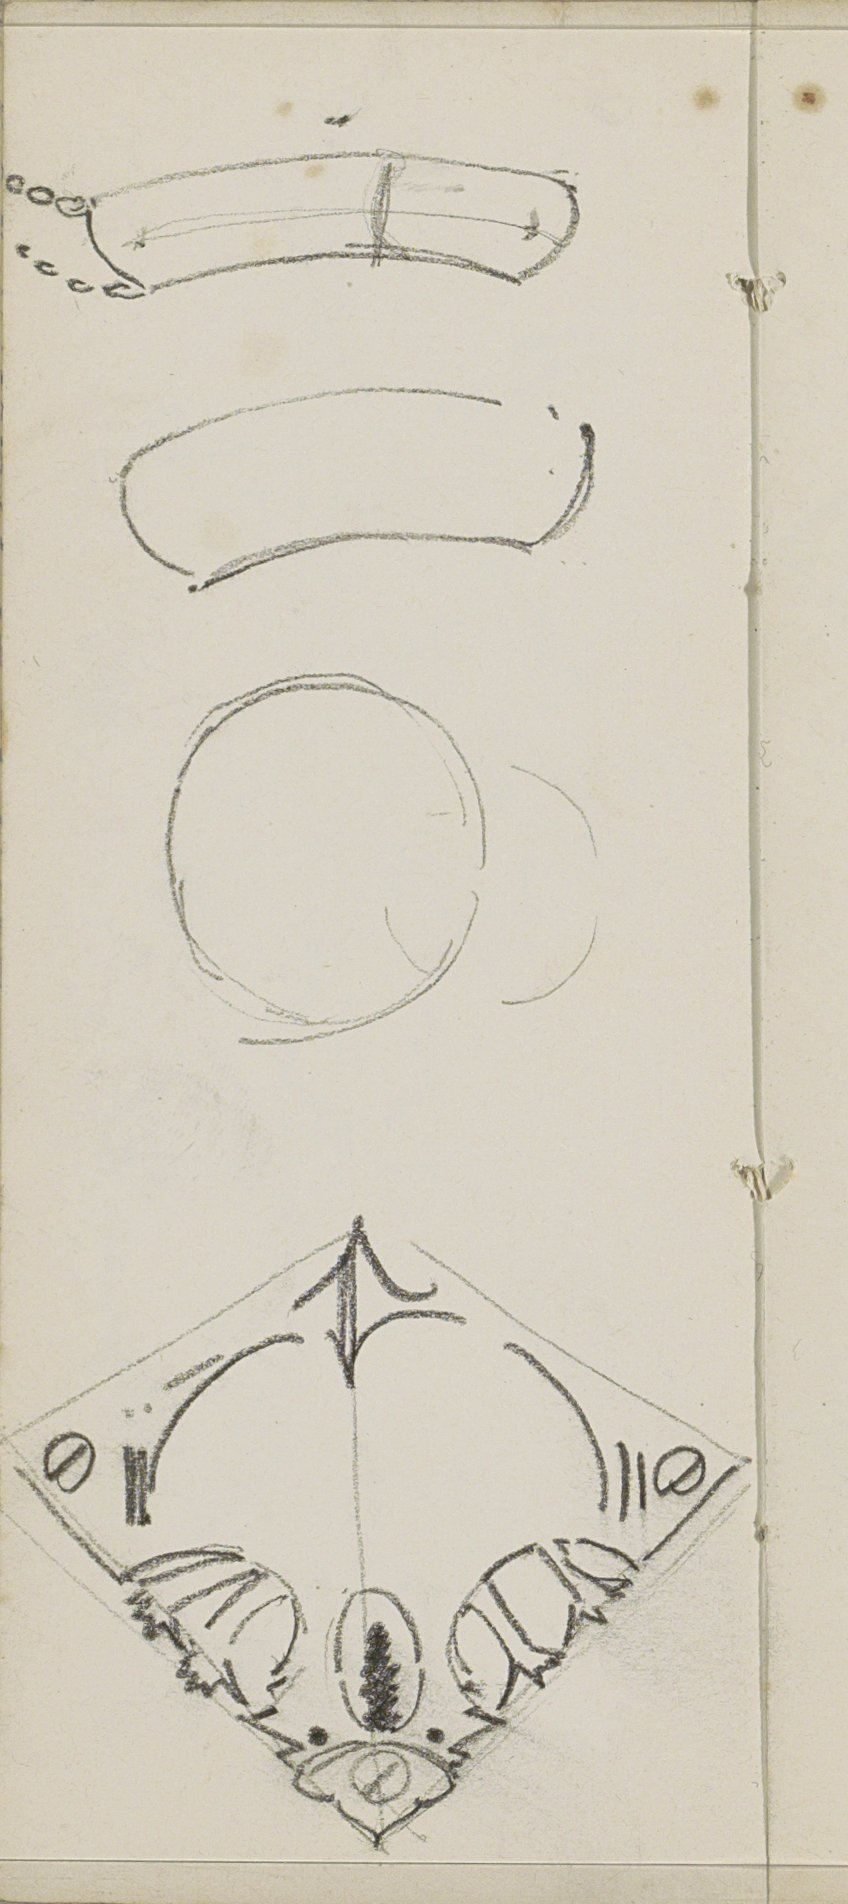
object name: sketchbook leaf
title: Ruitvormig ornament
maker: gerrit willem dijsselhof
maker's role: designer, draughtsman, print maker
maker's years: 1866-1924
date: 1876-1924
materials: chalk, paper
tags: lock ~ door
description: Tevens studies. Blad 32 verso uit een schetsboek met 40 bladen.